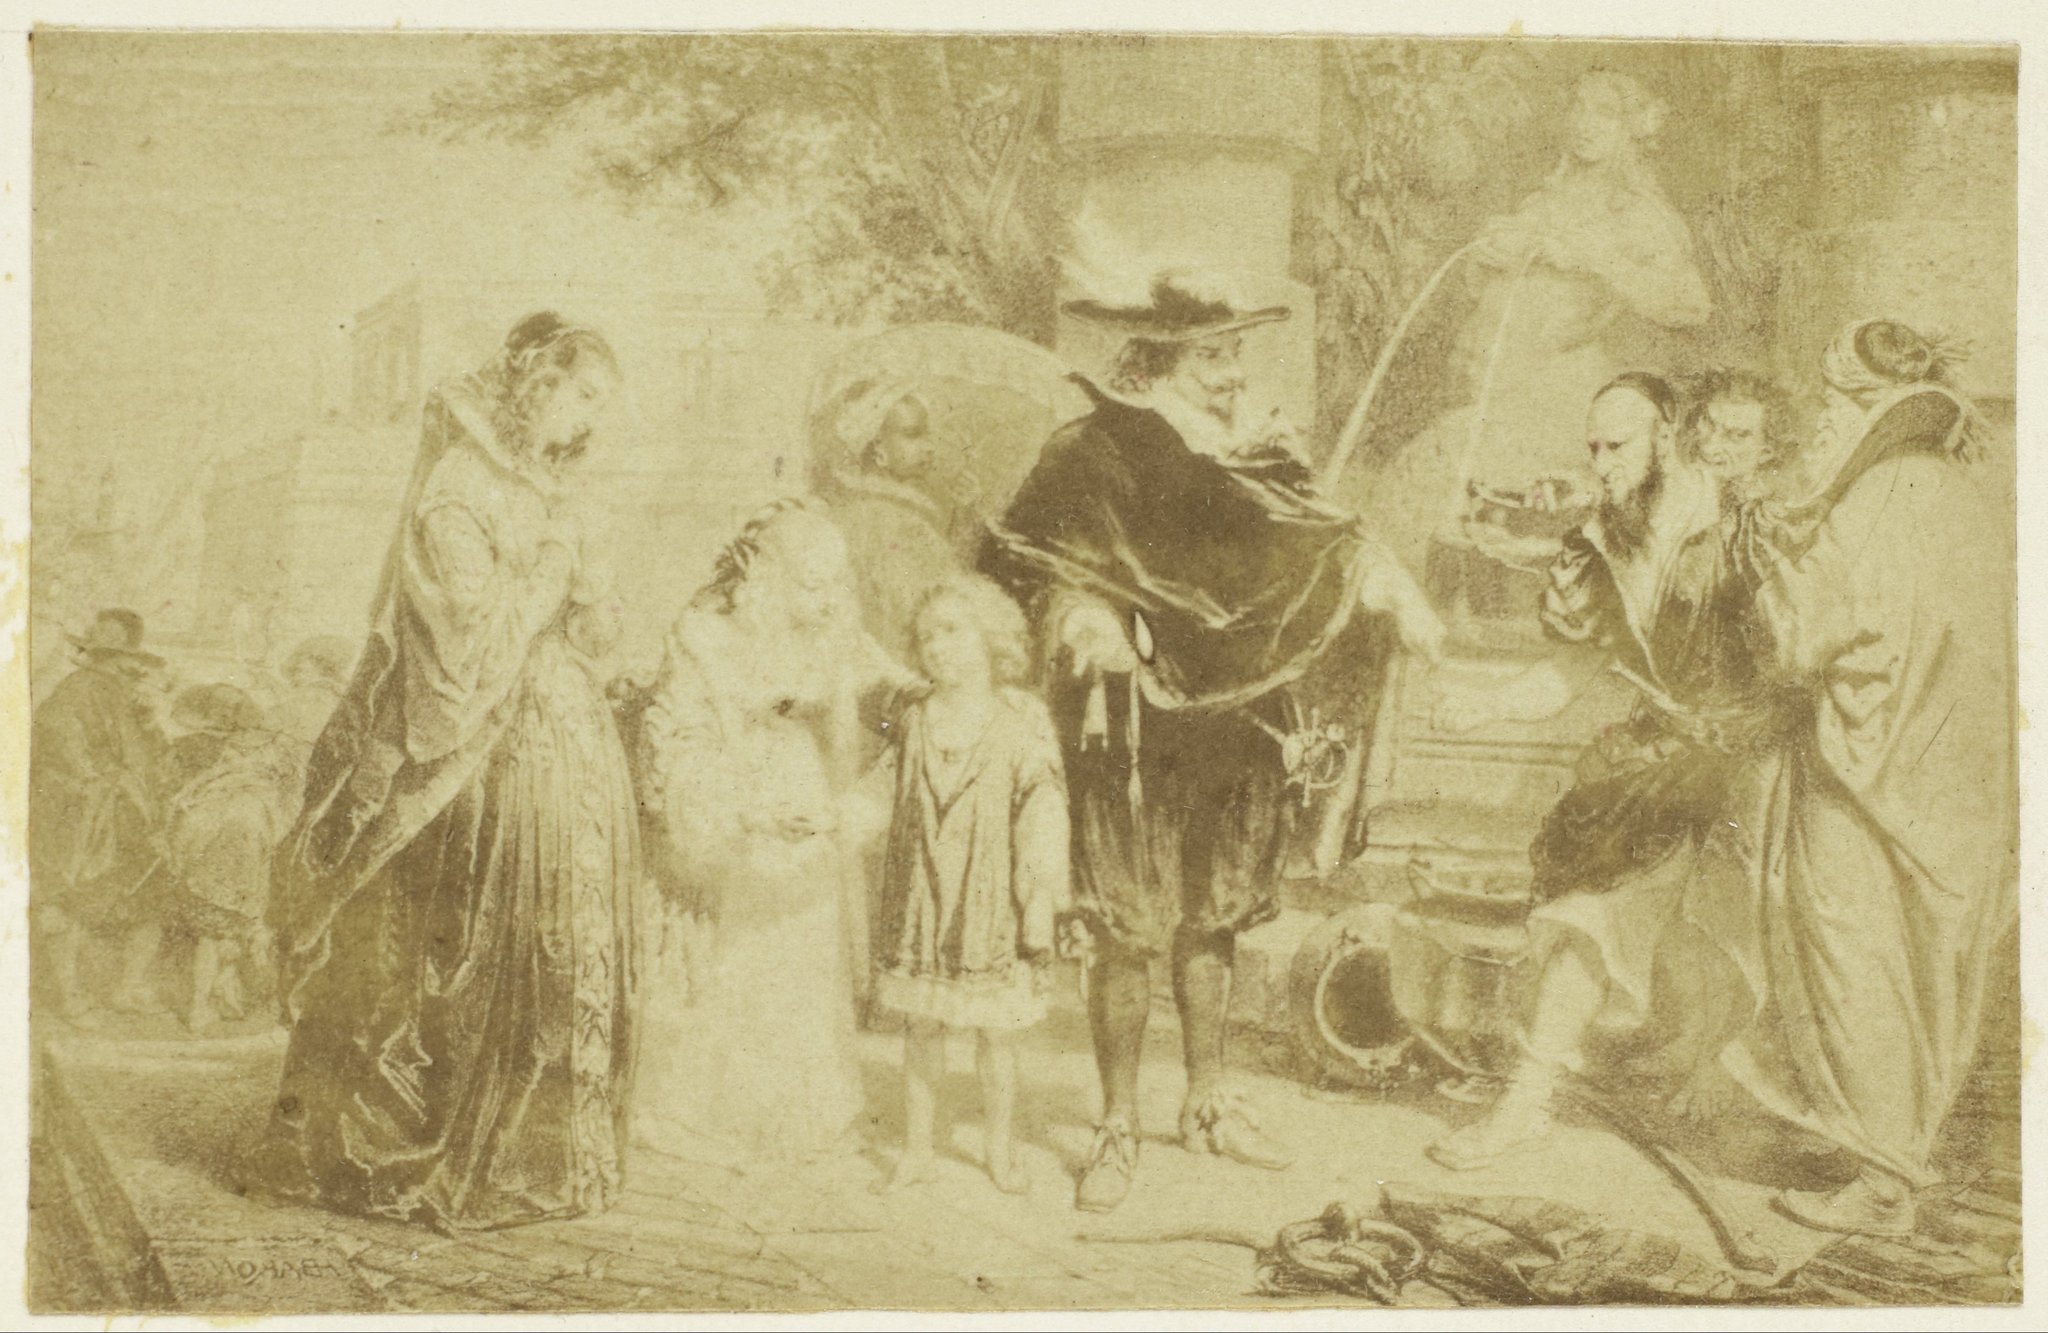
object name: photograph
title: Litho van Henri Baron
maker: eduard isaac asser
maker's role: amateurfotograaf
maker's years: 1809-1894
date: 1855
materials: cardboard, paper, photographic support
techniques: salted paper print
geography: amsterdam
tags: art (+ copy, copying ~ work of art)